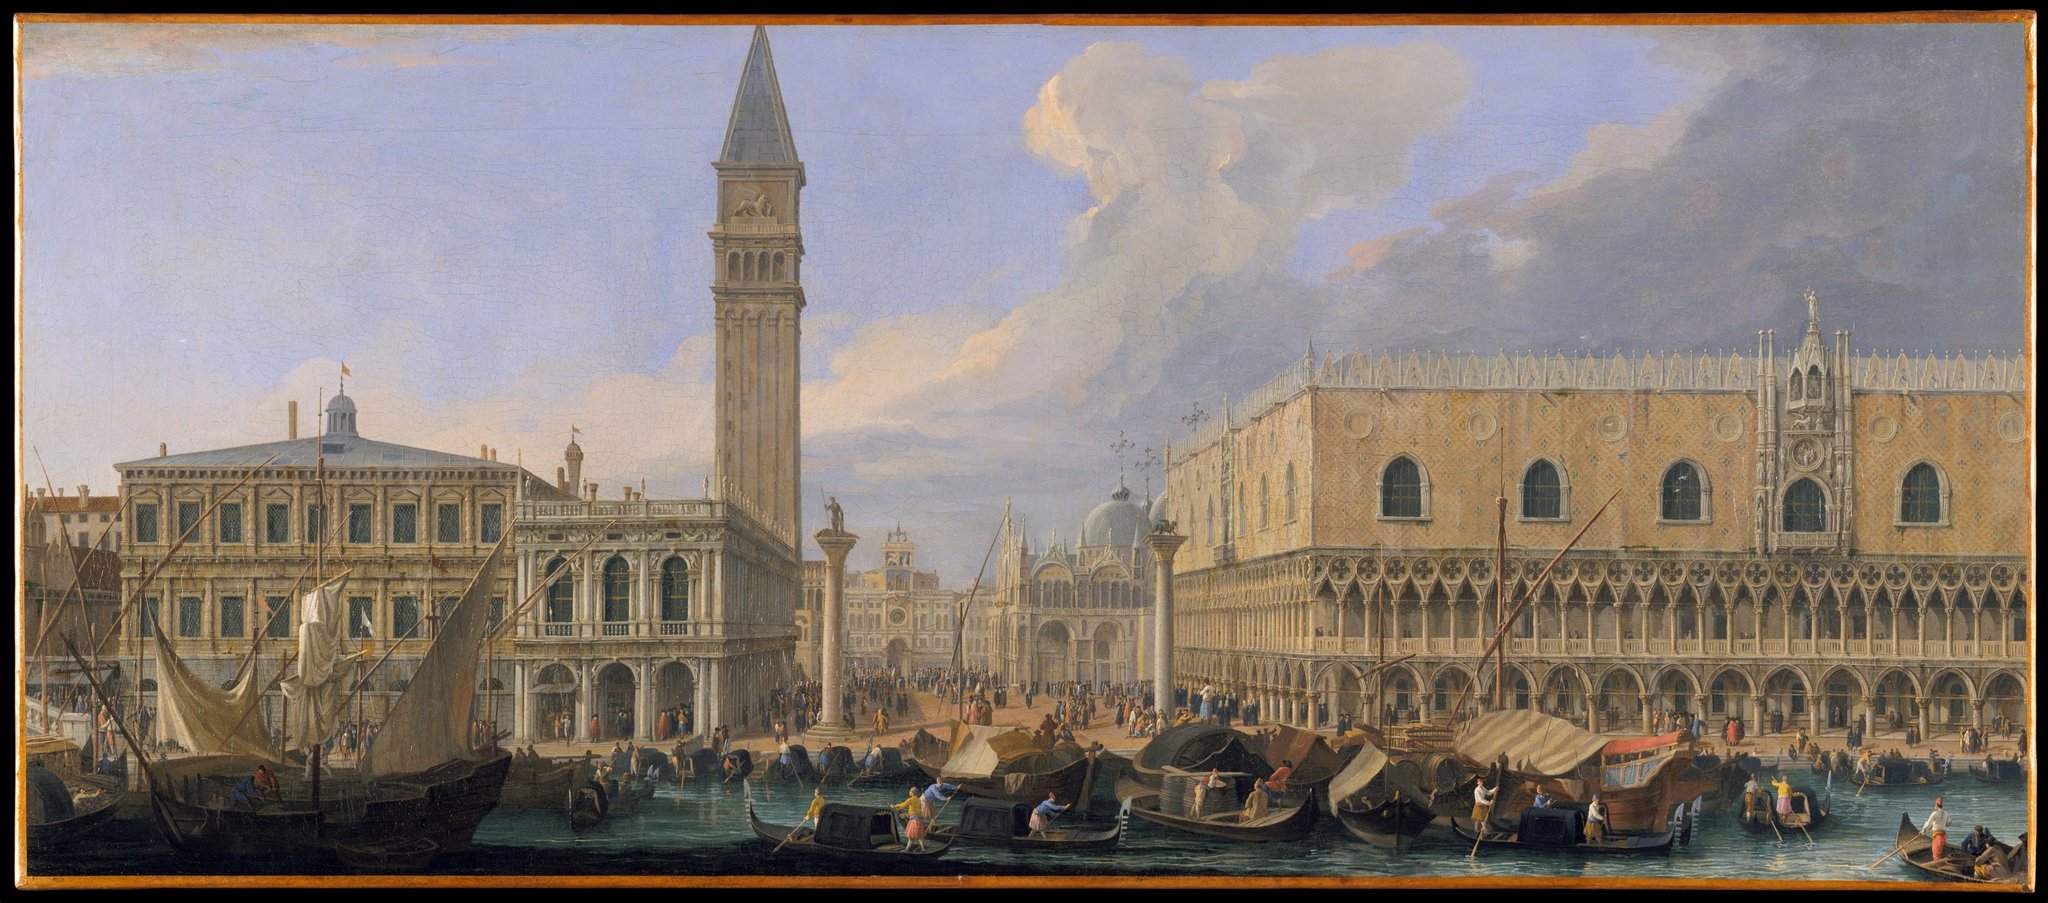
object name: painting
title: The Molo, Venice, from the Bacino di San Marco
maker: luca carlevaris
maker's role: artist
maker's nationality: italian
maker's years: 1663-1730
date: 1709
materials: canvas, oil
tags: buildings,cities,boats